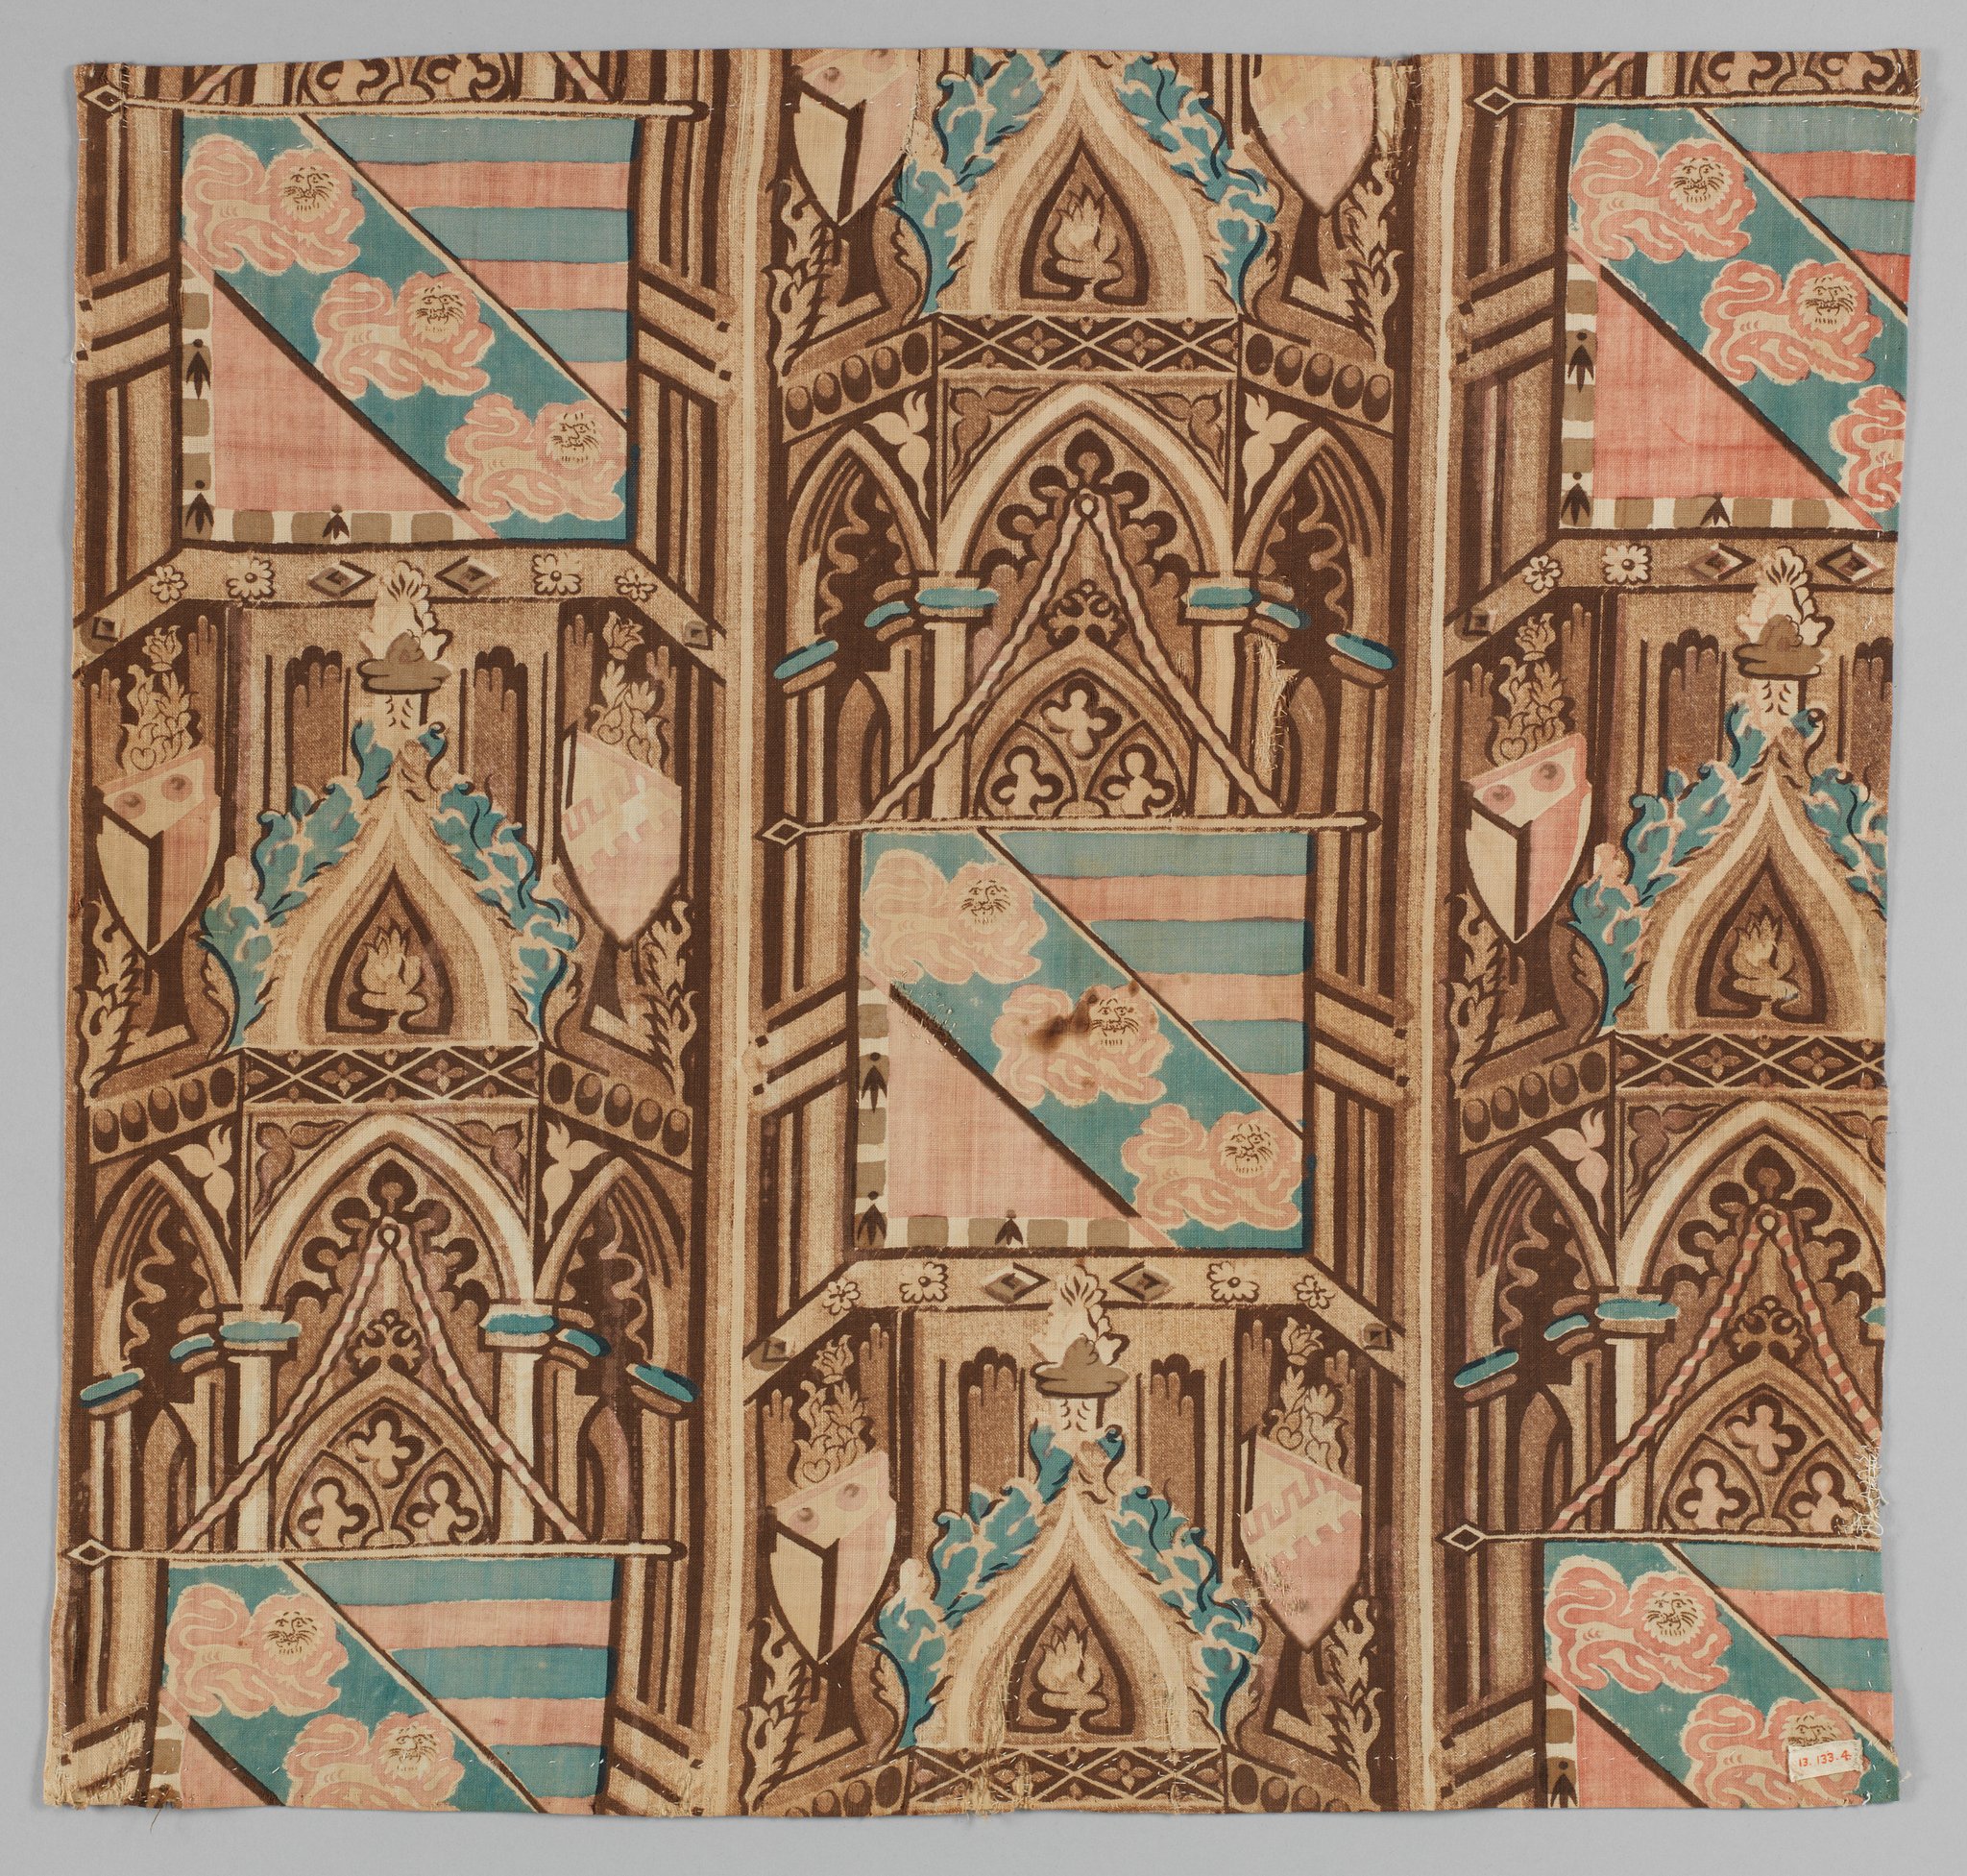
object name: piece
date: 1832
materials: cotton